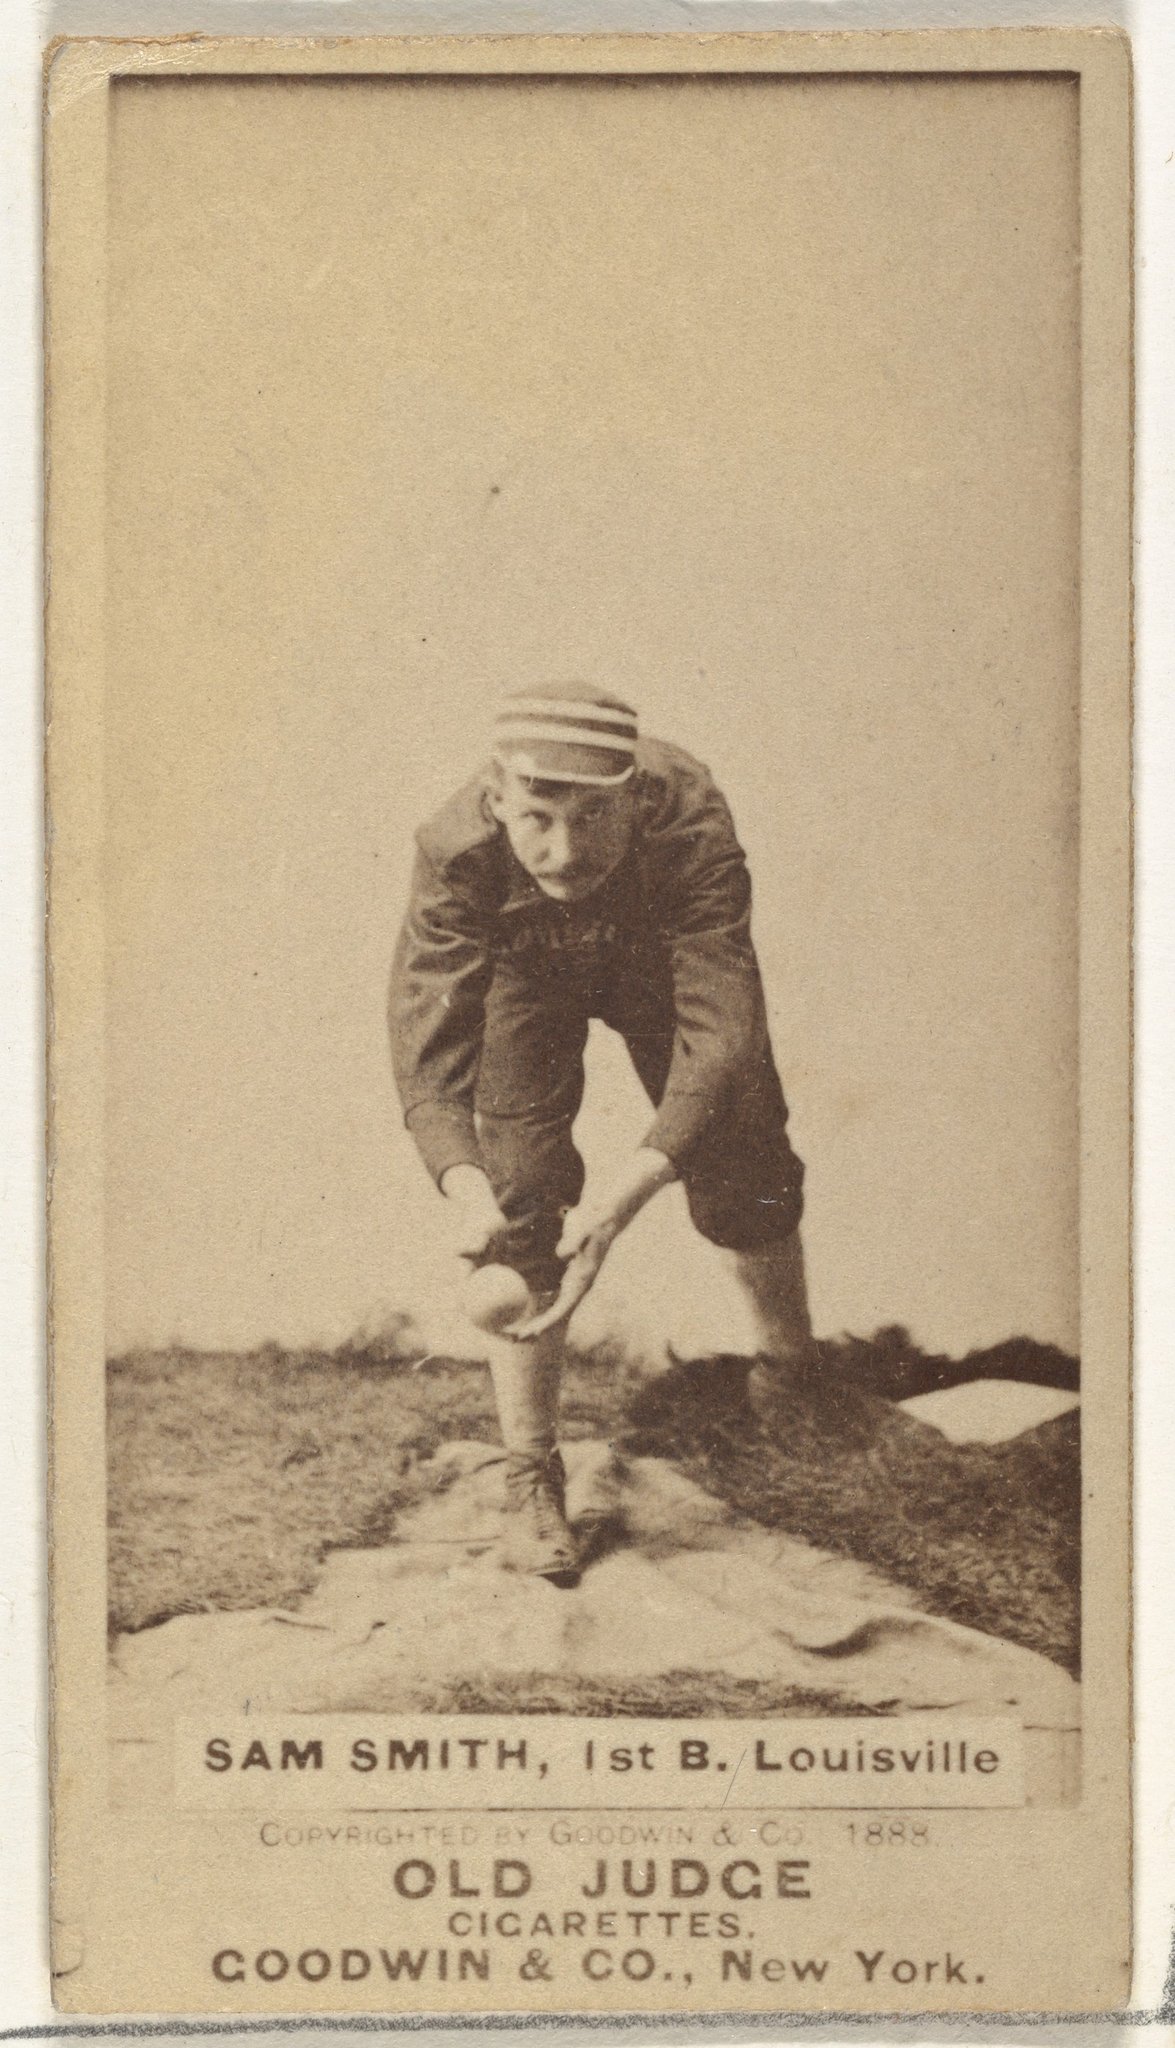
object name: baseball card, photograph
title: Samuel J. "Skyrocket" Smith, 1st Base, Louisville Colonels, from the Old Judge series (N172) for Old Judge Cigarettes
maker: goodwin & company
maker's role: publisher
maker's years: 1850-1950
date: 1888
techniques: albumen silver print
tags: men,portraits,baseball,athletes